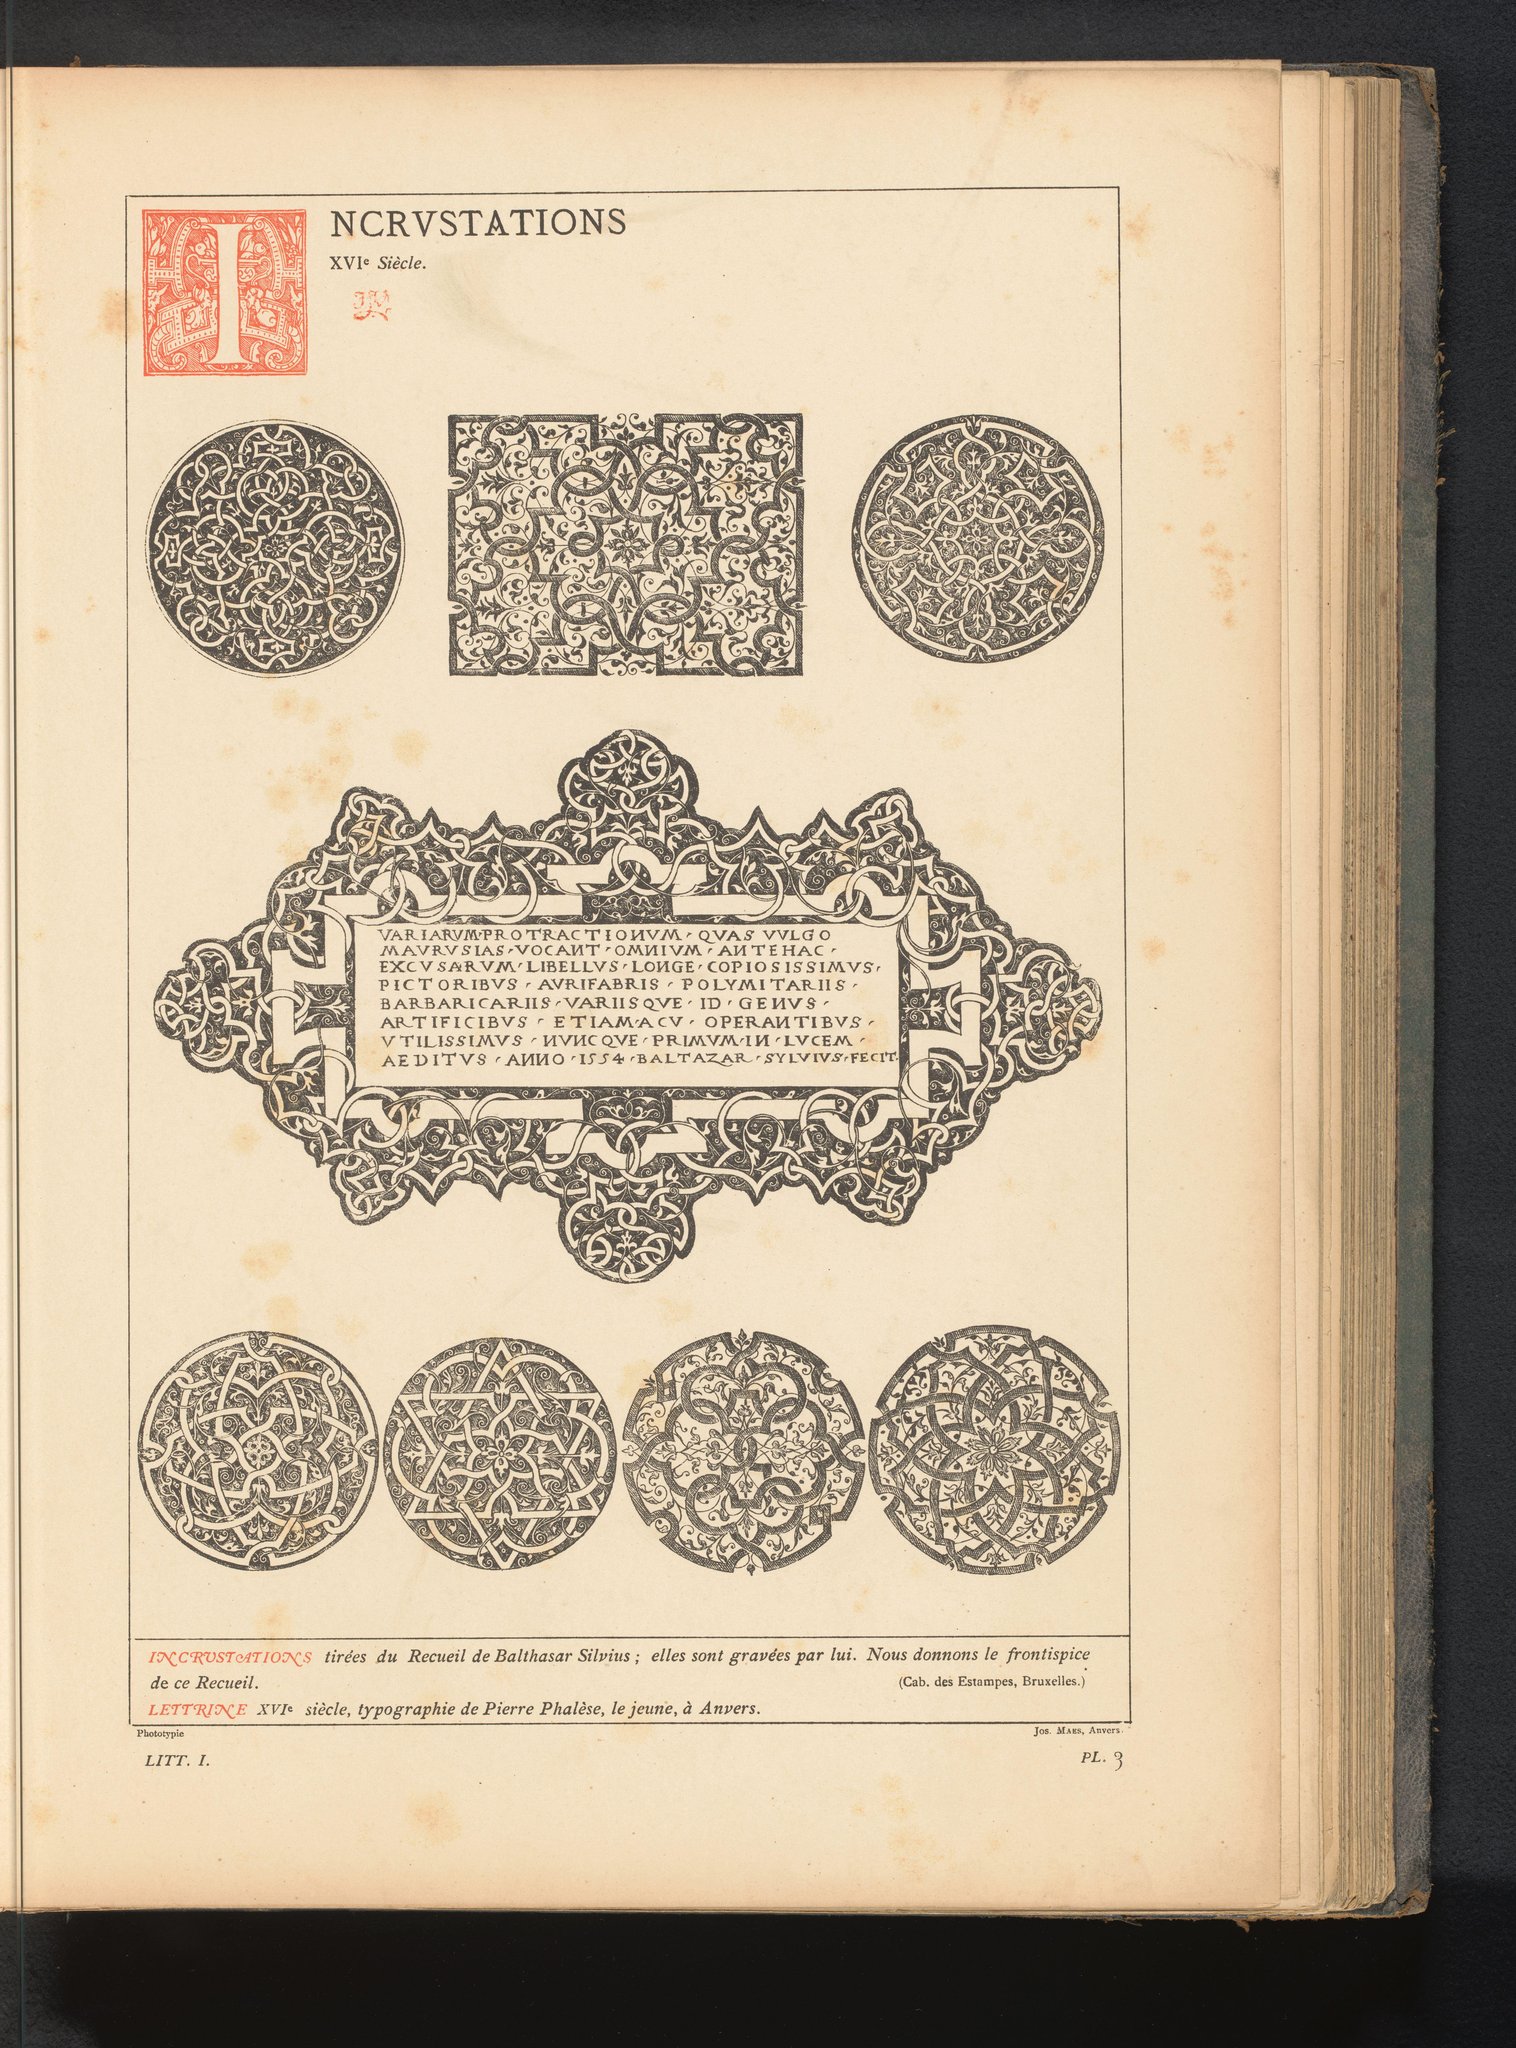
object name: page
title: Reproductie van een titelpagina met acht decoraties van houtsnijwerk door Balthazar van den Bos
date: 1875-1880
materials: paper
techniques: photolithography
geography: antwerp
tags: title-page, sculpture (+ relief ~ sculpture)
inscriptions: inscription: ‘INCRUSTATIONS tirées du (...)’, monogram: ‘JJvY’, inscription: ‘LITT. I. - PL. 3’